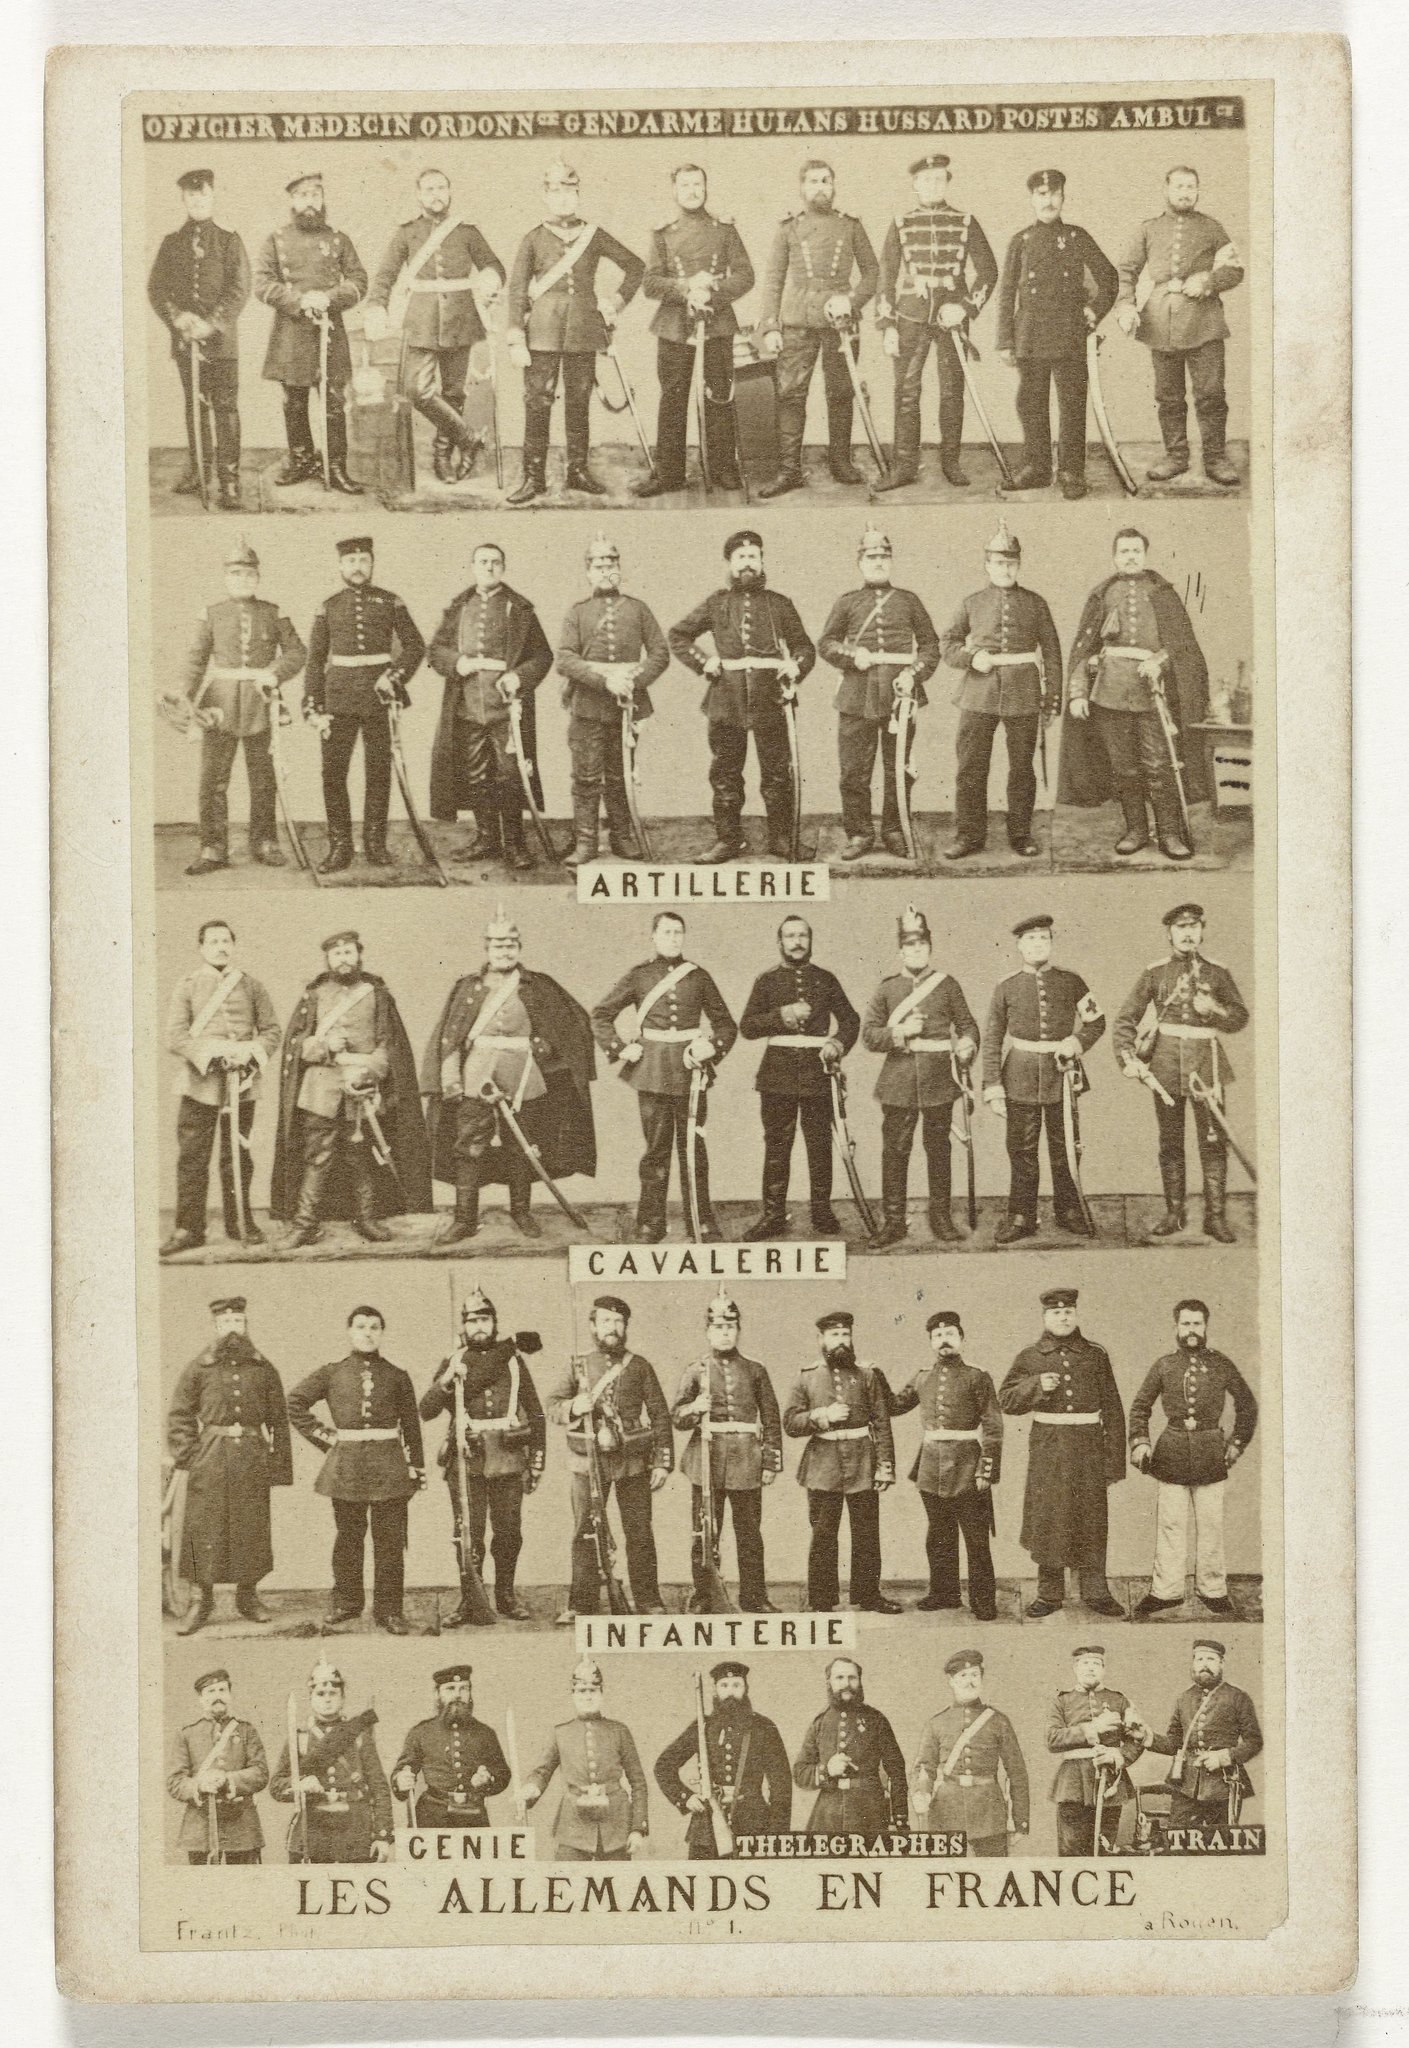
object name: photograph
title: Soldiers and Officers in the Franco-Prussian War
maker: frantz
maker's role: fotograaf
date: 1870-1871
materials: paper, photographic support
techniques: albumen print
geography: france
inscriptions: annotation: ‘OFFICIER MEDECIN ORDONNCE GENDARME HULANS HUSSARDS POSTES AMBULCE / ARTILLERIE / CAVALERIE / INFANTERIE / GENIE / TELEGRAPHES / TRAIN / LES ALLEMANDS EN FRANCE / Frantz Phot a Rouen’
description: France and Germany went to war in 1870. After a swift victory, Germany occupied a part of France. Rouen, where the maker of these photographs lived, lay in this area. Perhaps his fellow citizens used them to identify the foreign soldiers. In any case, they were small enough to fit into a coat pocket and could be consulted inconspicuously.